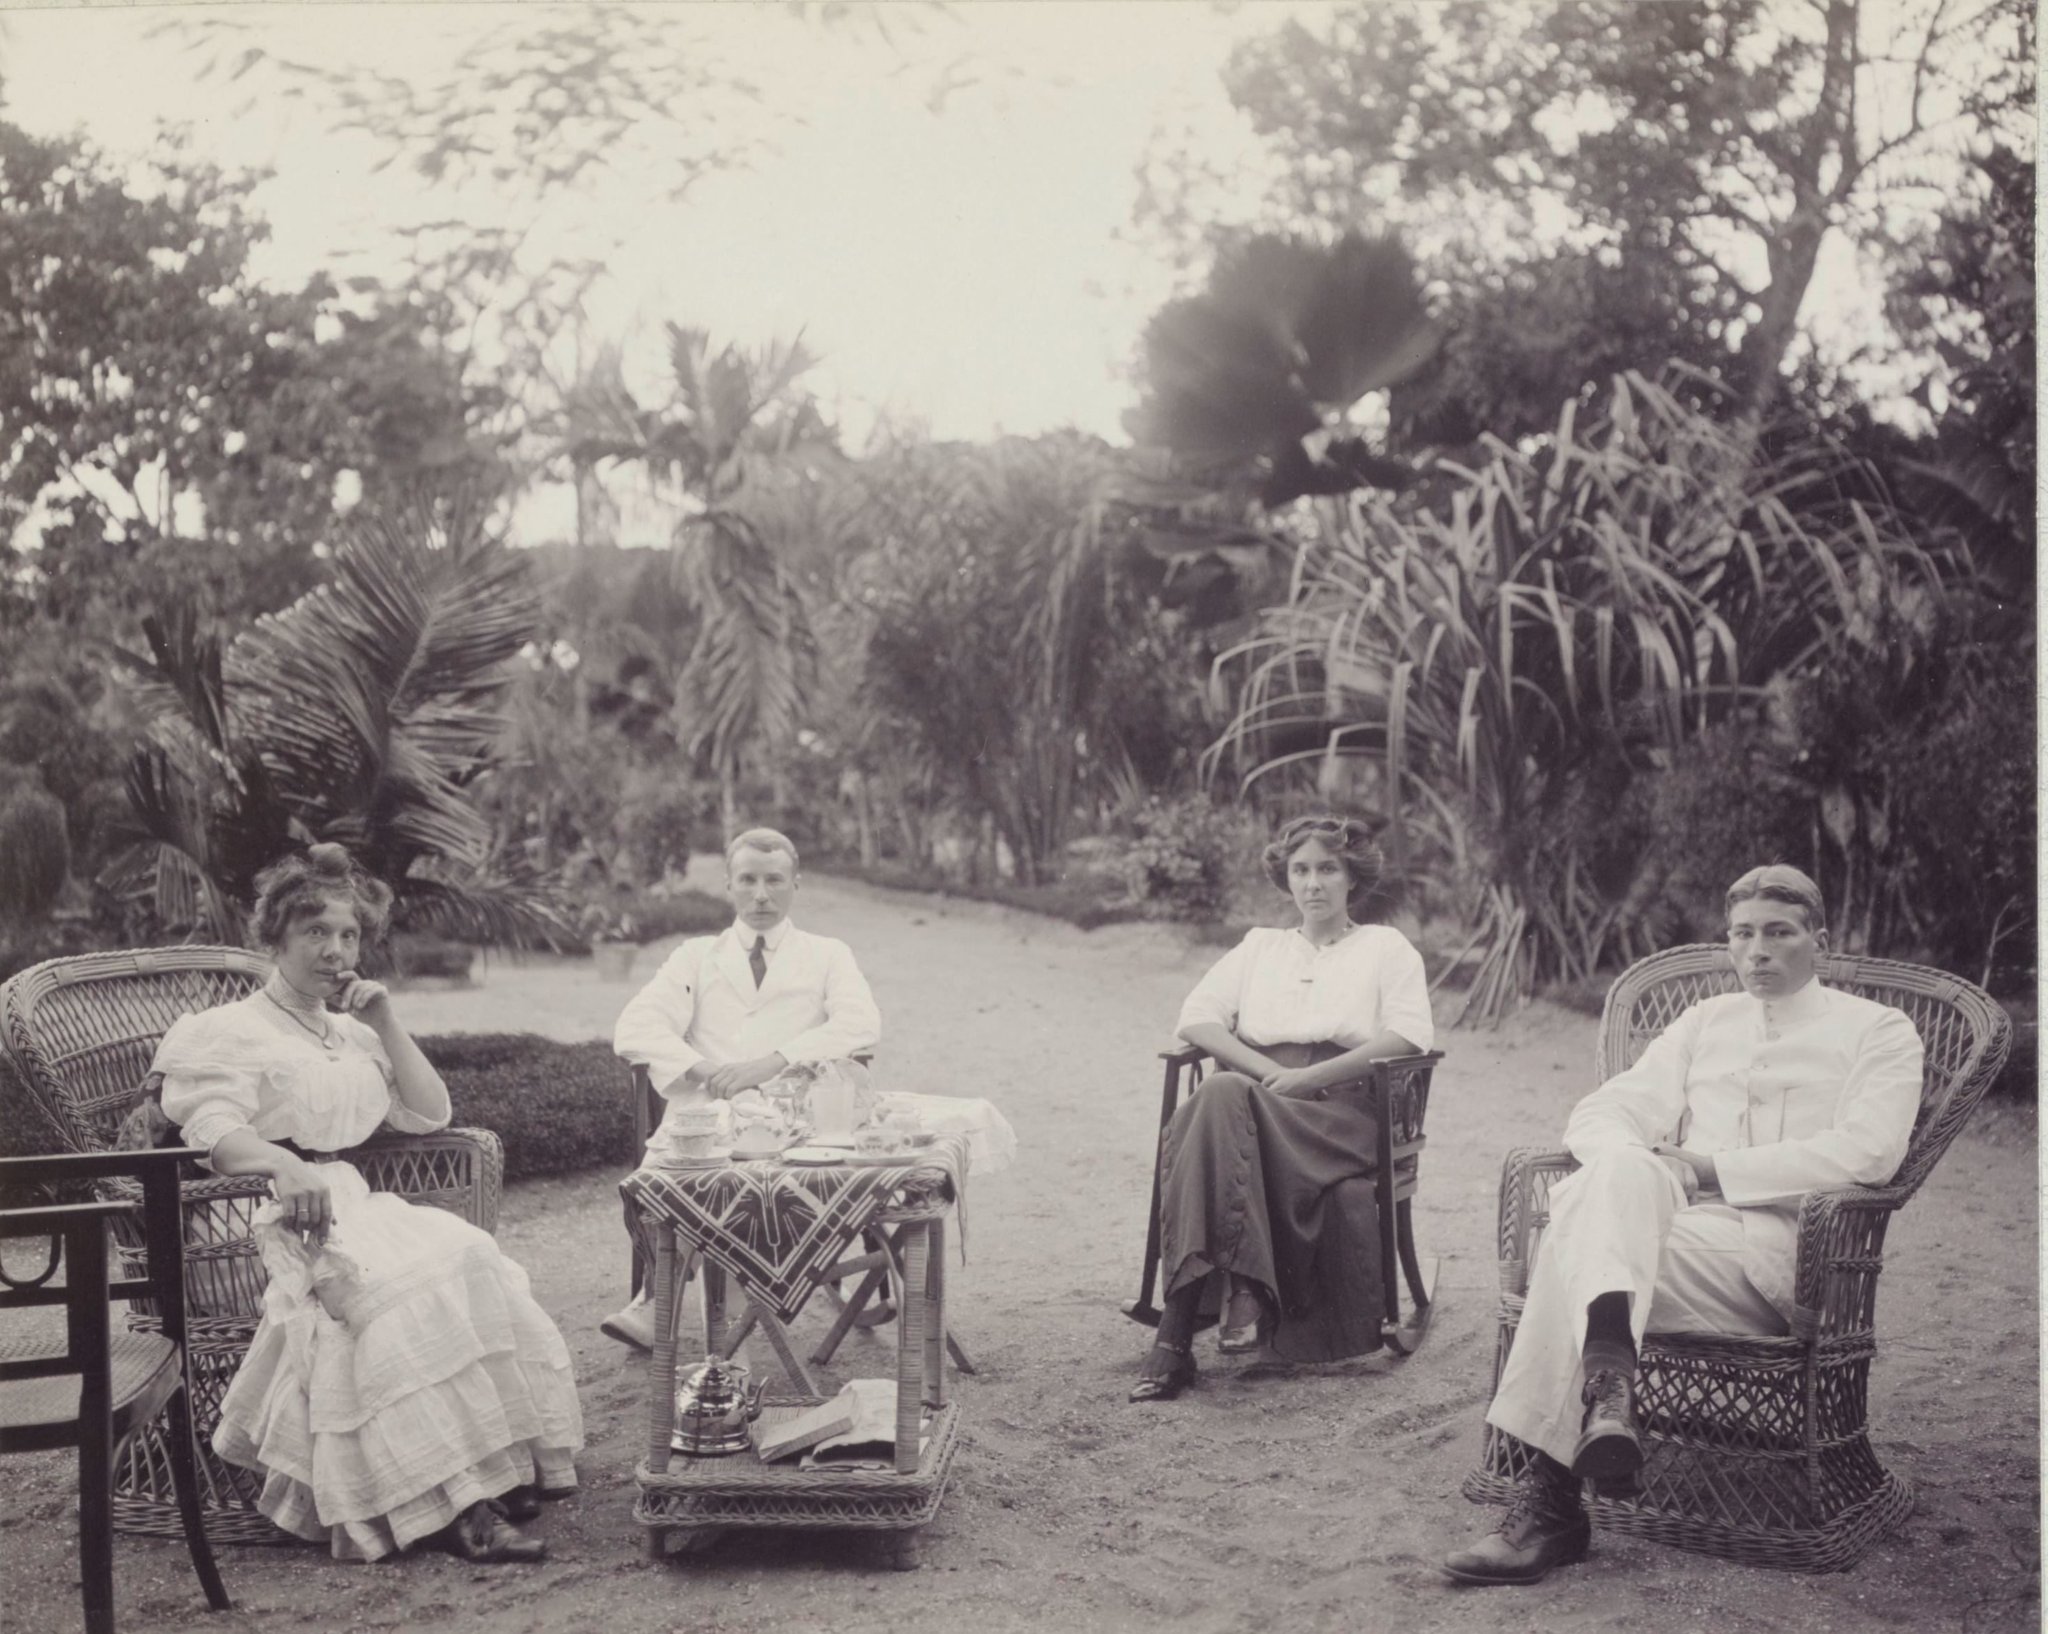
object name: photograph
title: Gezelschap in tuin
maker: Anonymous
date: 1911-1912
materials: photographic support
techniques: photography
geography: suriname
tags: andries augustus boom, suriname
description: Maria Gonggrijp en Andries Boom zittend in een tuin samen met een andere man en vrouw. Onderdeel van het fotoalbum van de familie Boom-Gonggrijp in Suriname en Curaçao.